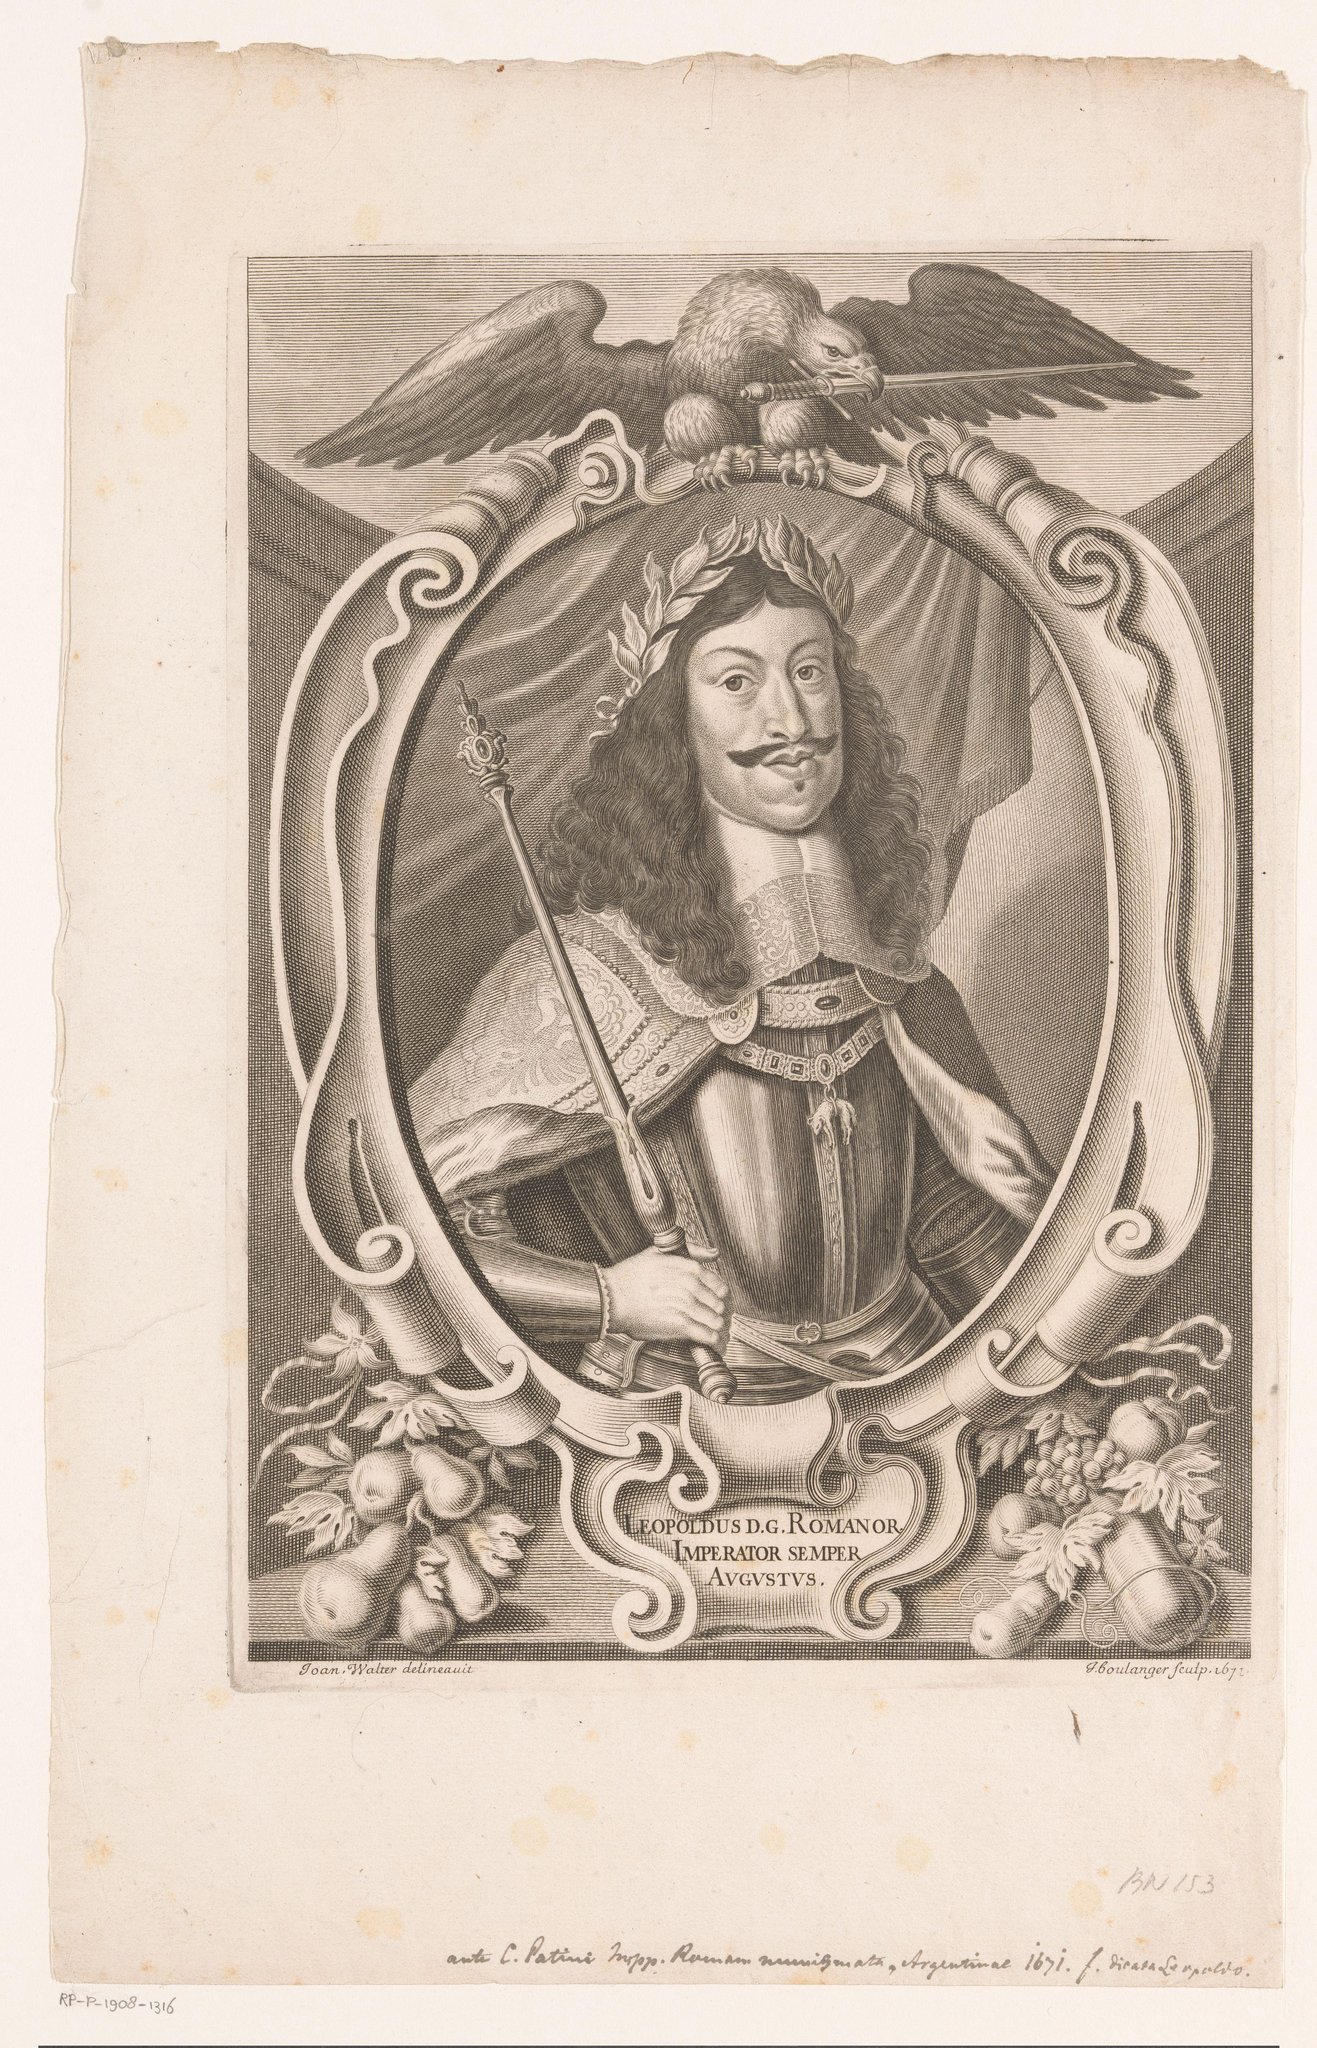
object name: print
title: Leopoldus D.G. Romanor. Imperator Semper Augustus.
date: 1671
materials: paper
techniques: engraving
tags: vienna, leopold i (keizer van duitsland), historical persons, emperor, knighthood order of the golden fleece - insignia of a knighthood order, e.g.: badge, chain (with name of order), crowning with laurel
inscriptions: collector's mark: Lugt 2228